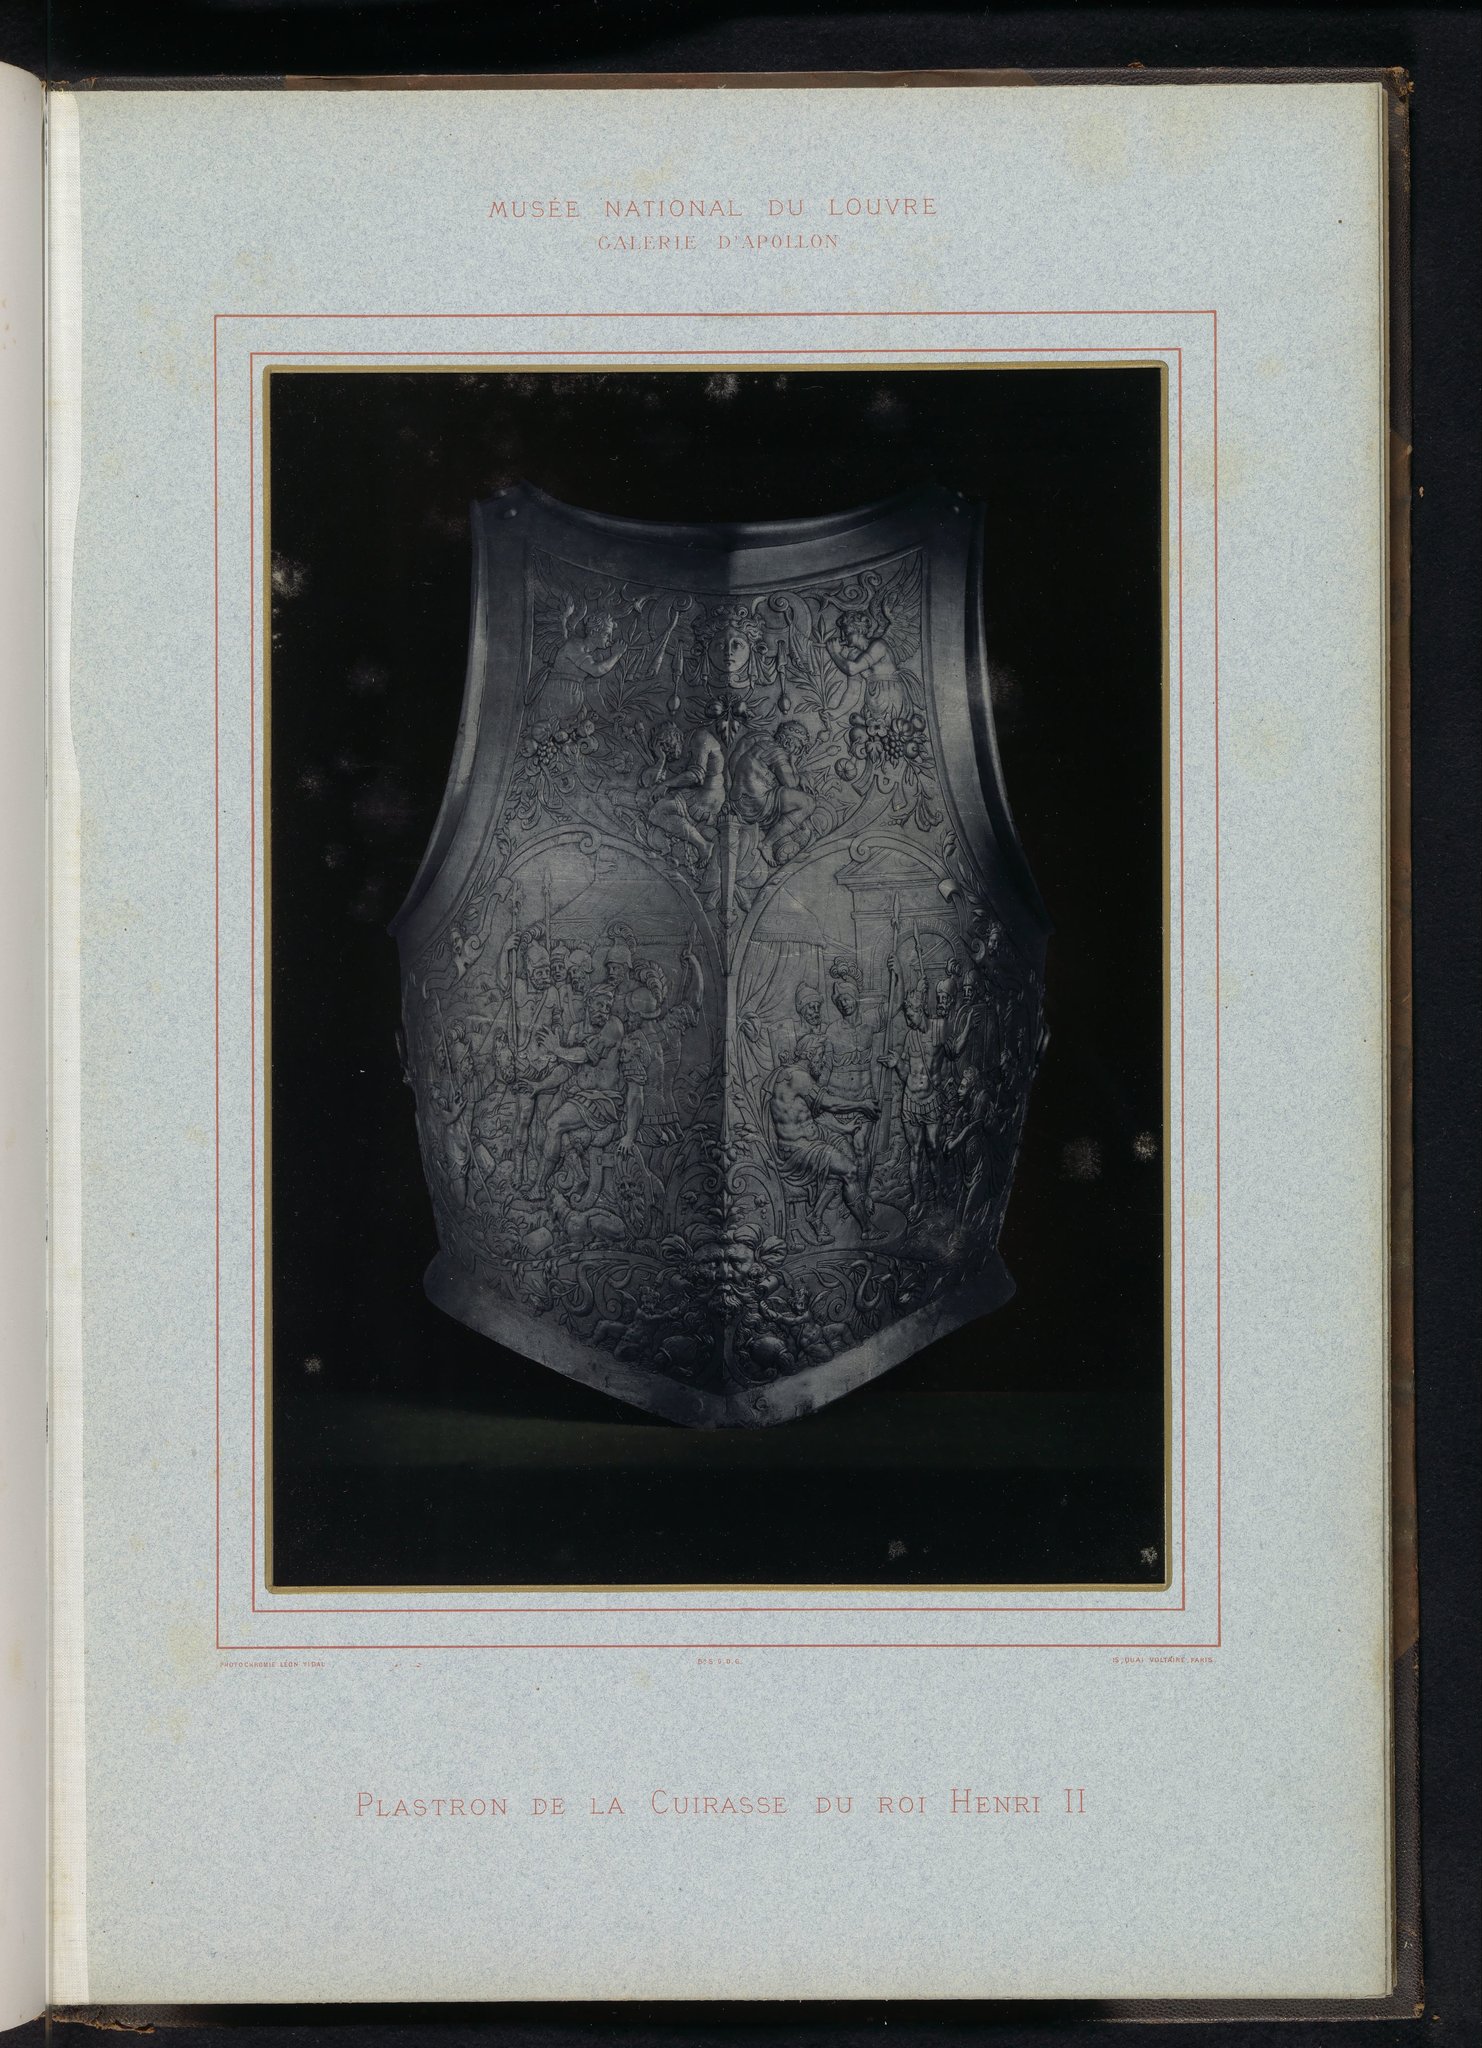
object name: photomechanical print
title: Borstplaat van het harnas van koning Henri II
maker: léon vidal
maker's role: fotograaf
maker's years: 1833-1906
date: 1876-1883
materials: paper, photographic process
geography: paris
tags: armour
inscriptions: inscription: ‘Musée National du Louvre Galerie d'Apollon’, inscription: ‘[...]e l[...]’, inscription: ‘15 Quai Voltaire. Paris.’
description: RP-F-2001-7-1545B-9 toont de voorkant van de borstplaat, RP-F-2001-7-1545B-10 toont de achterkant van de borstplaat.